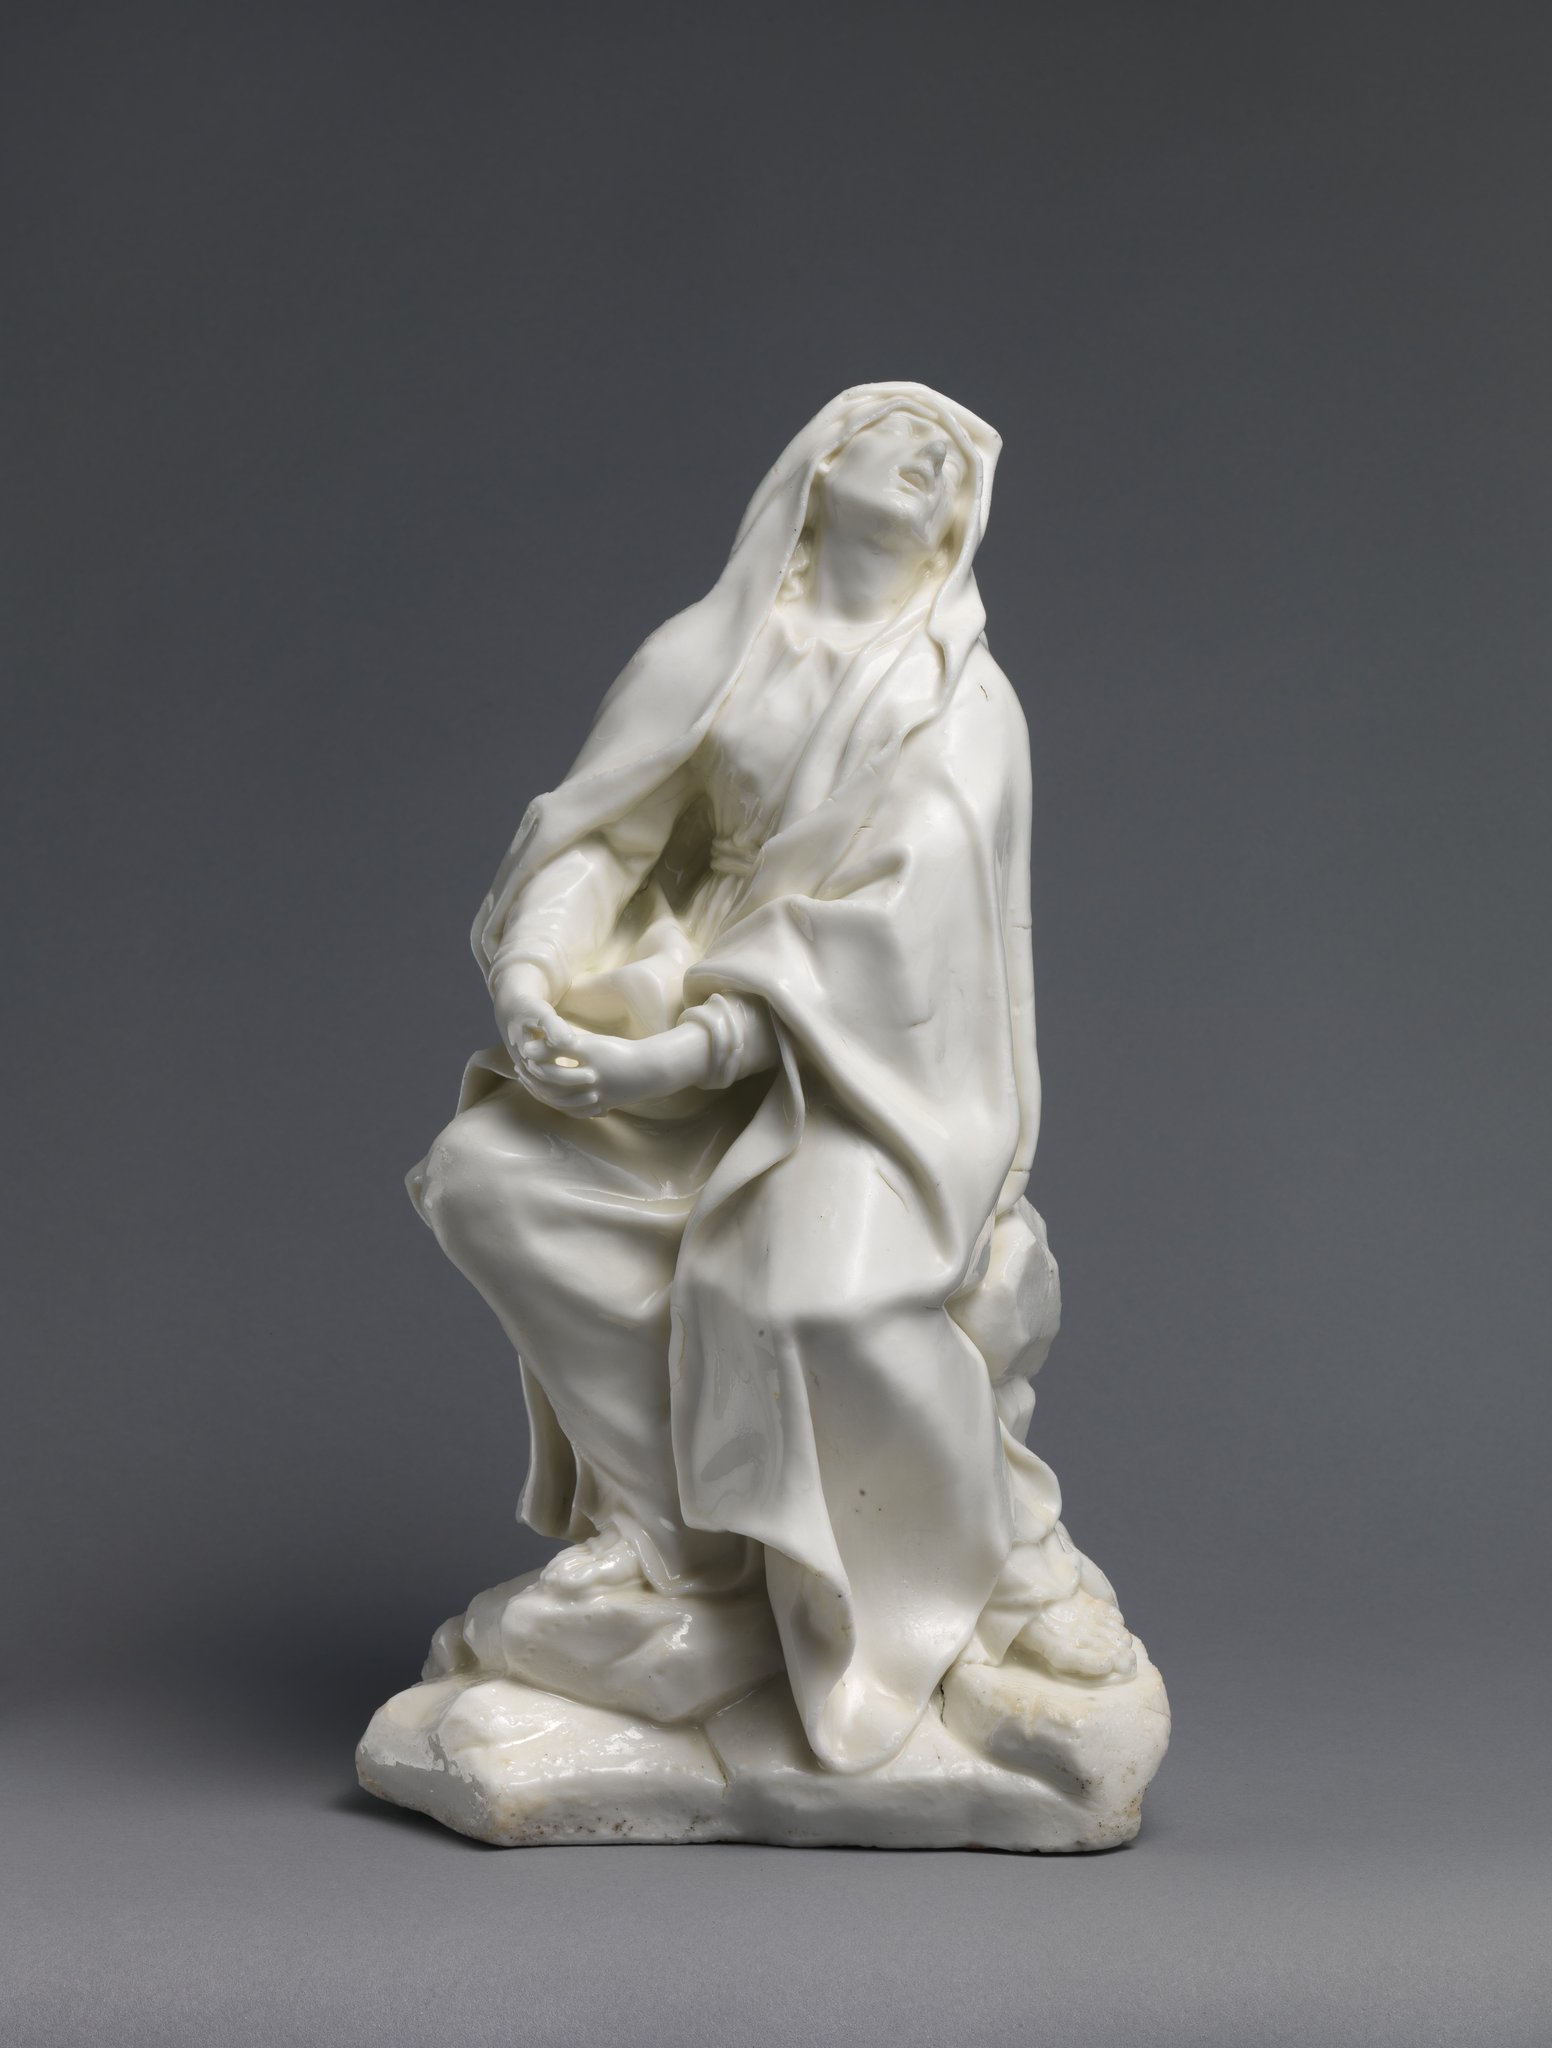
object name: figure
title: The Mourning Virgin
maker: capodimonte porcelain manufactory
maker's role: manufactory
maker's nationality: italian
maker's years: 1740-1759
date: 1744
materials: soft paste porcelain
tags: suffering,virgin mary